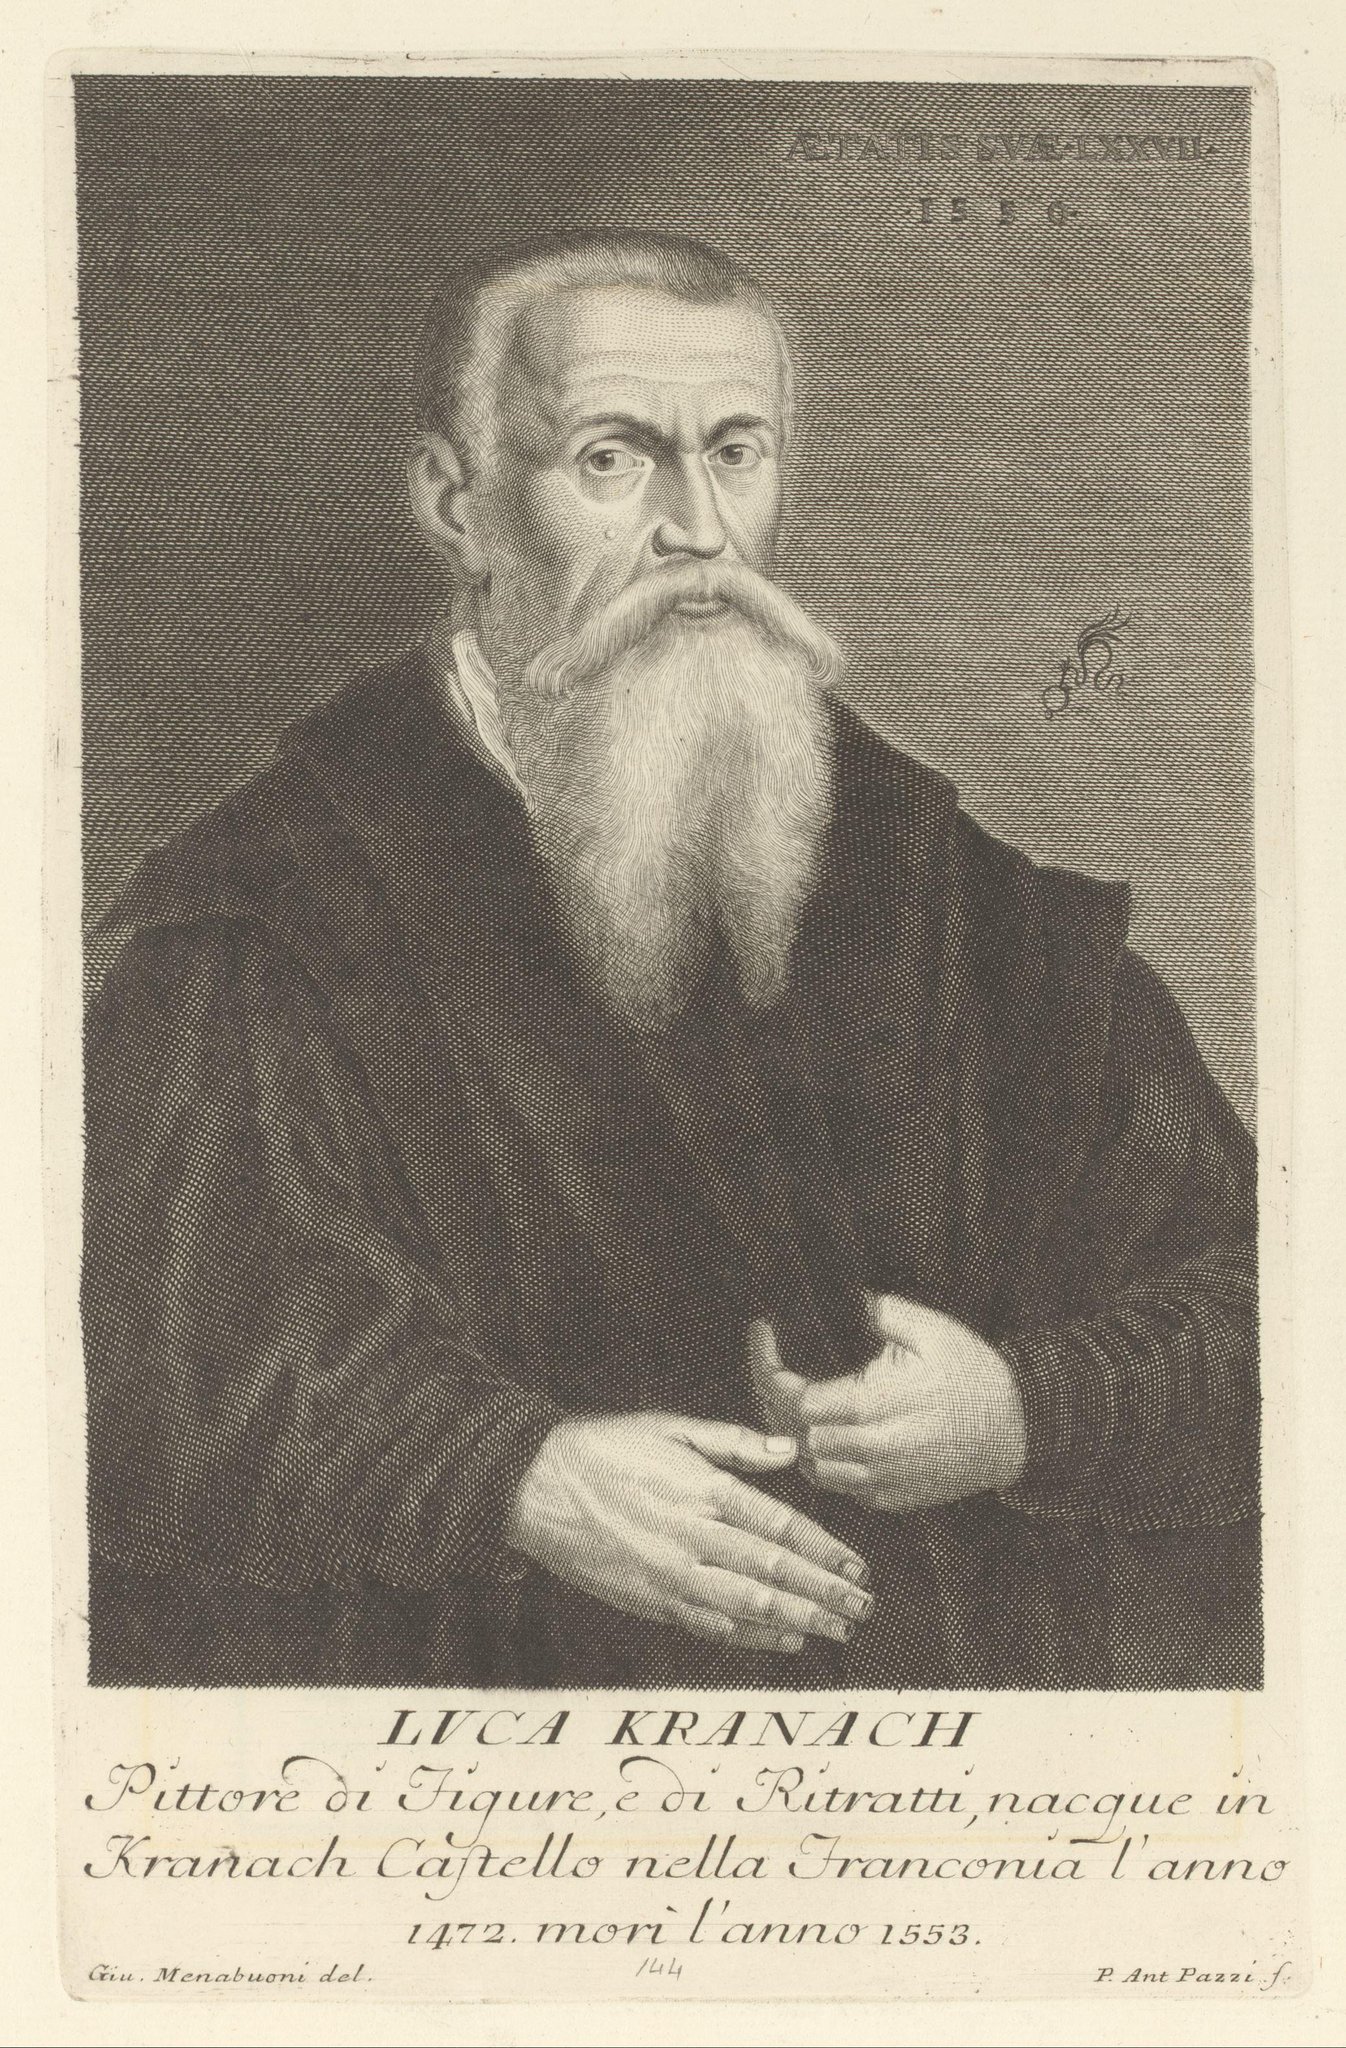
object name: print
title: Portret van Lucas Cranach op 77-jarige leeftijd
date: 1752-1766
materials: paper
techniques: engraving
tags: print maker, draughtsman, lucas cranach (i), historical persons, portrait, self-portrait of painter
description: Prent is onderdeel van een serie getiteld 'Museum Florentinum', bestaande uit vier subsecties: 'Gemmae antiquae ex Thesauro Mediceo et privatorum dactyliothecis florentiae...' (1730-1731), 'Statuae antiquae dorum et virorum illustrium' (1734), 'Antiqua numismata aurea et argentea' (1740-1741) en 'Serie di ritratti degli eccellenti pittori' (1752-1766). Het vierde deel bestaat uit 320 kunstenaarsportretten en is uitgegeven in boekvorm (vier delen). Prent uit: Moücke, Francesco. Serie di ritratti degli eccellenti pittori : dipinti di propria mano che esistono nell'Imperial galleria di Firenze. 4 dln. Florence: Francesco Moücke, 1752, dl. 1, p. 22. De samensteller heeft deze prent in het album geplakt als illustratie bij: Pilkington, Matthew en Johann Heinrich Füssli. A dictionary of painters, from the revival of the art to the present period. 4 dln. Londen: John Crowder, 1805, dl. 1, p. 143.